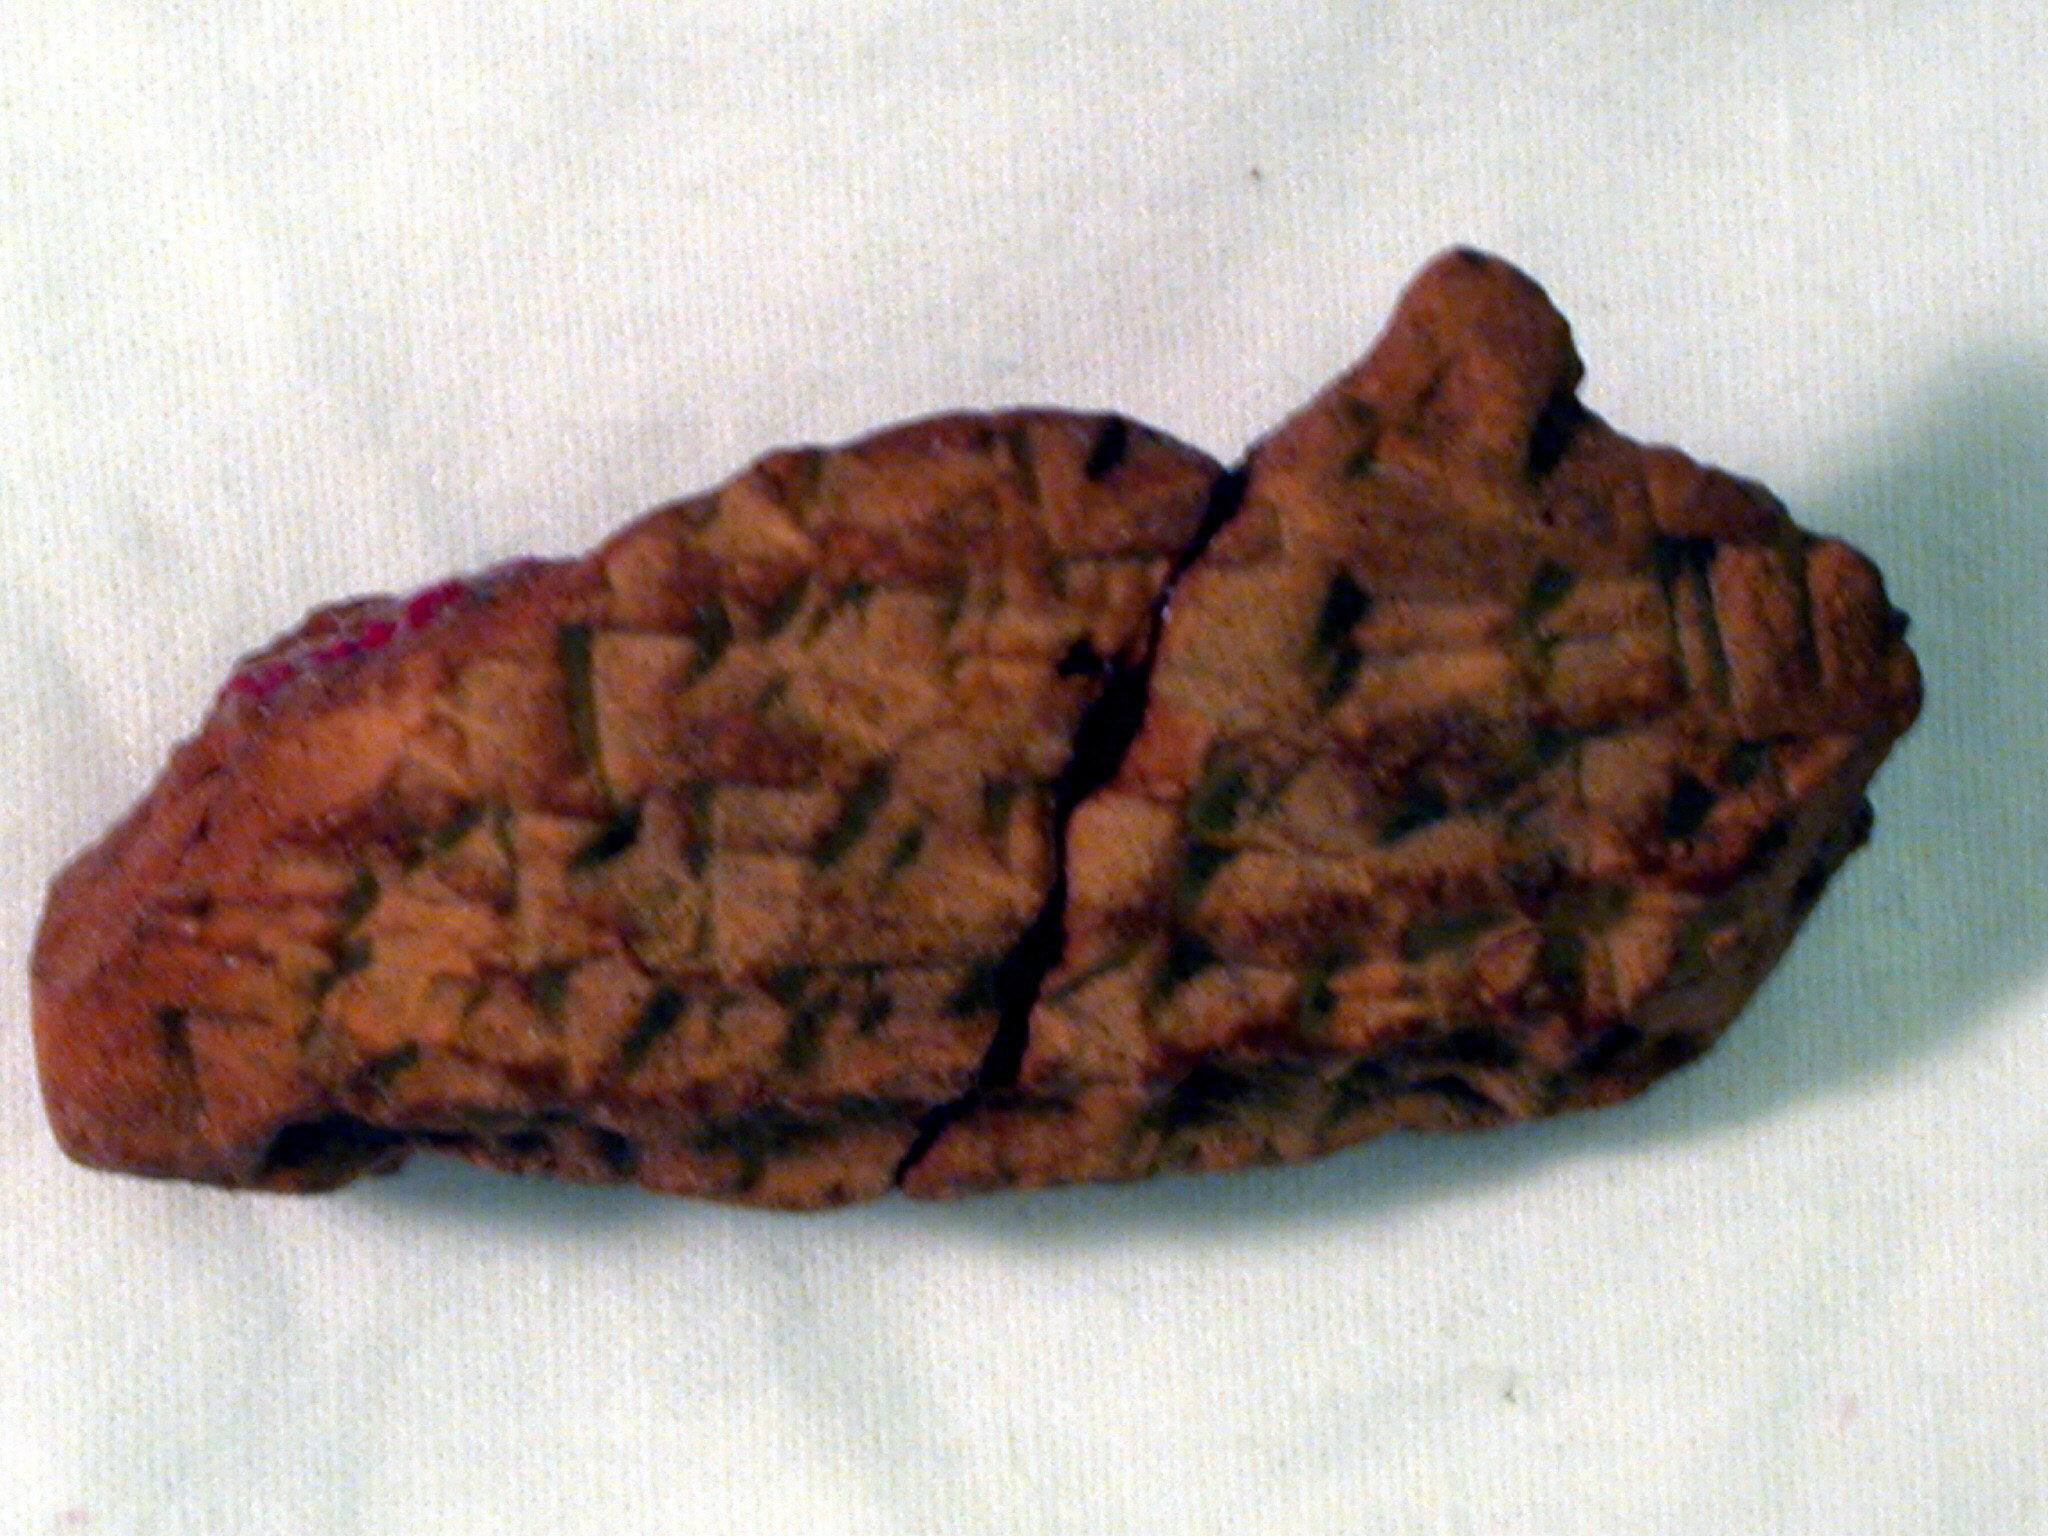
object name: cuneiform tablet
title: Cuneiform tablet: account of delivery of field rent, Ebabbar archive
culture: babylonian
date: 700-501 BCE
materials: clay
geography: mesopotamia